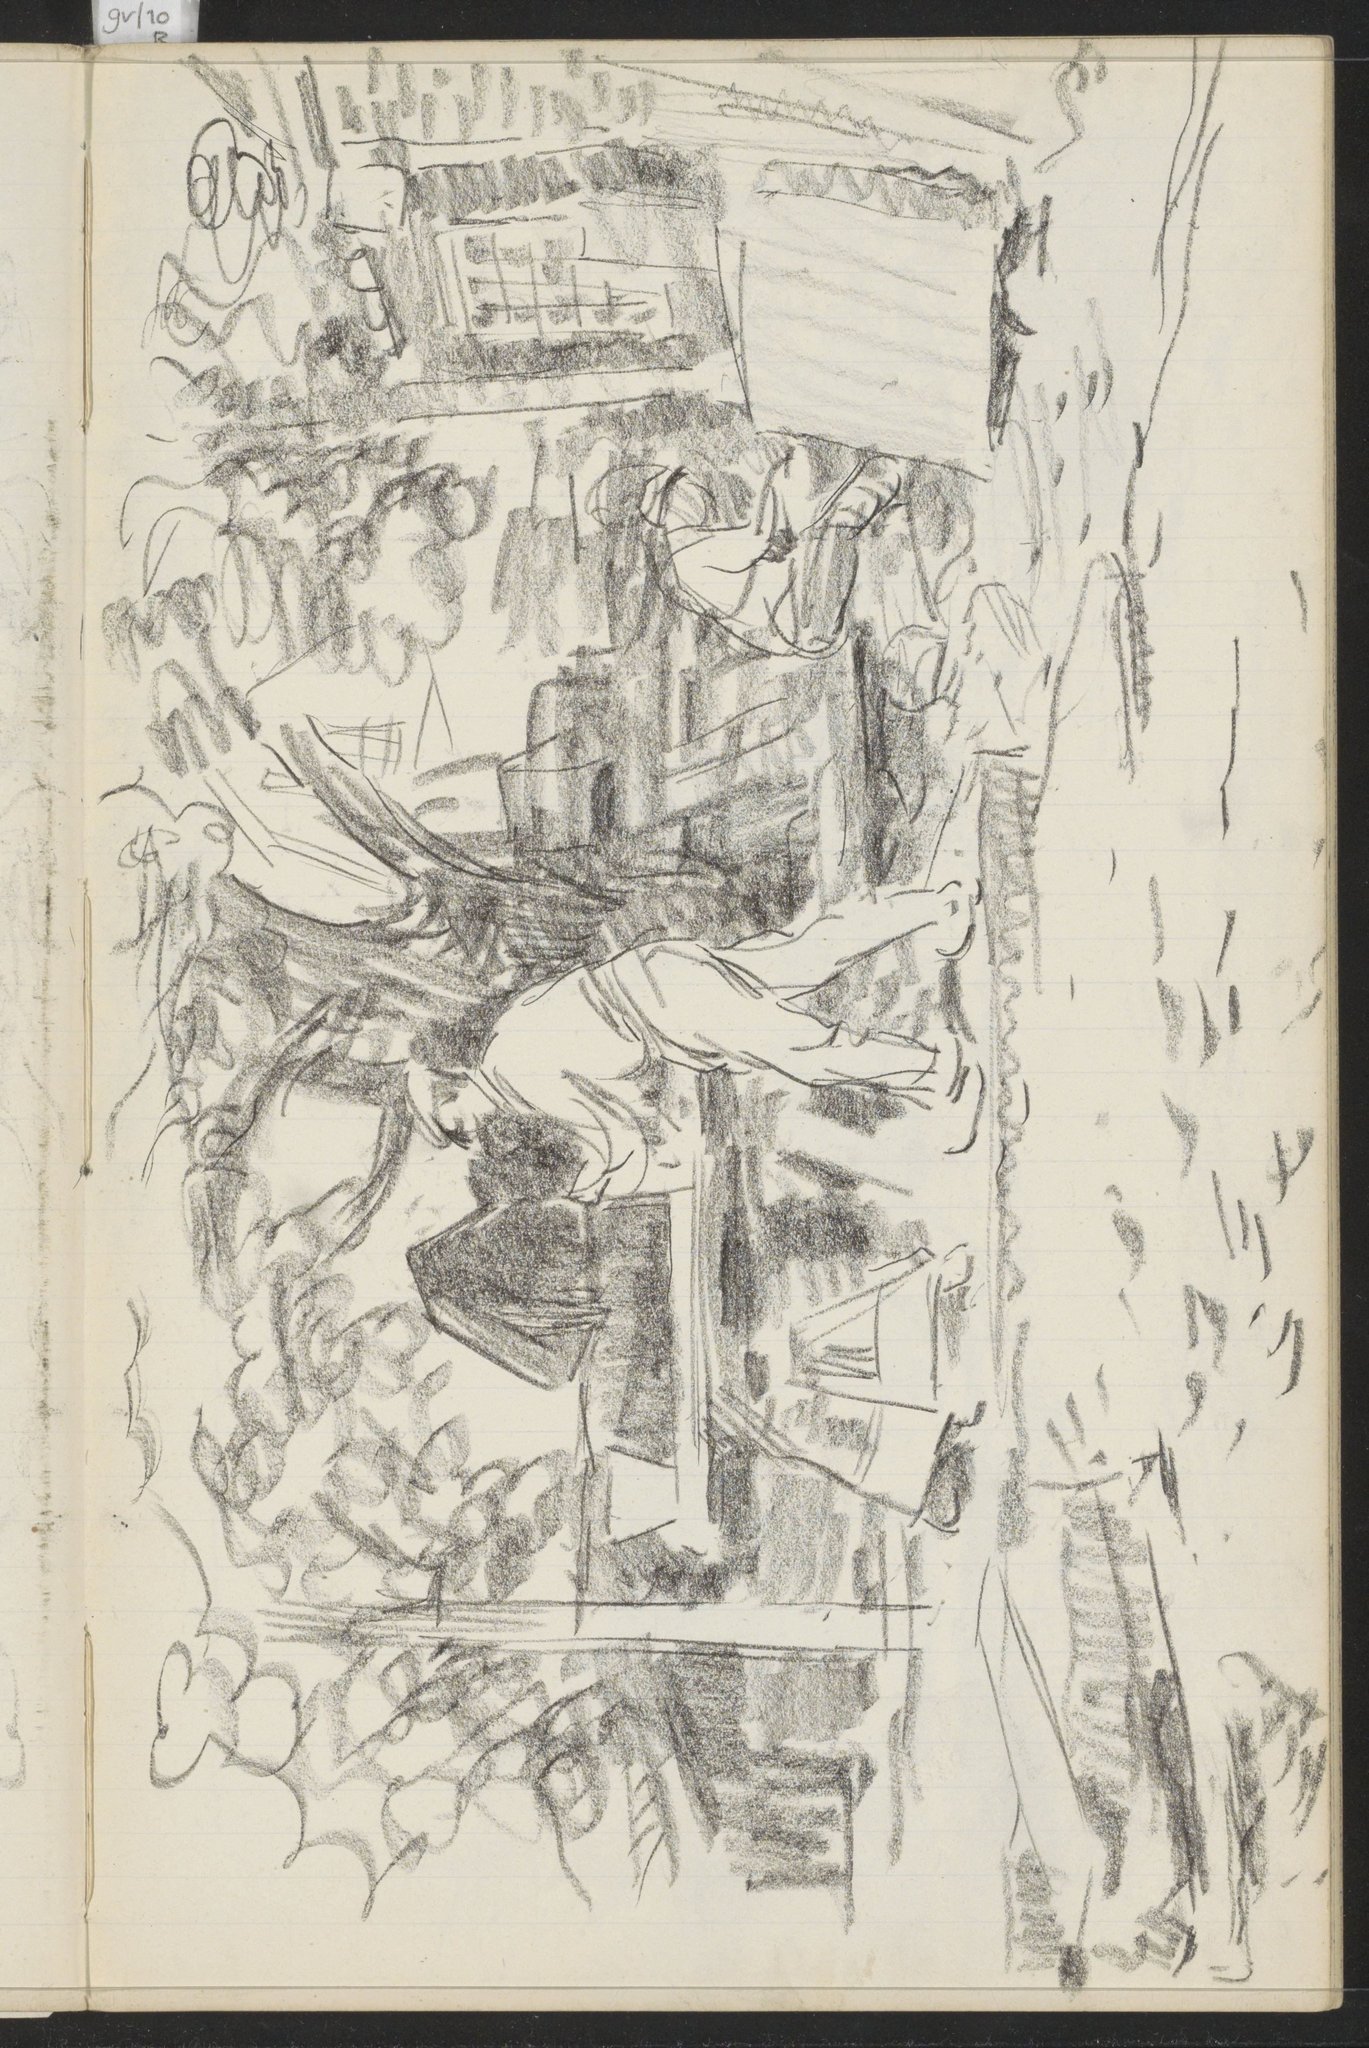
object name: sketchbook leaf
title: Twee mannen bij een werkbank in een steenhouwerij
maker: willem bastiaan tholen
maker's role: draughtsman, painter, print maker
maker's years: 1860-1931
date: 1900-1931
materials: chalk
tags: workbench, garden, adult man, workshop, handicrafts ~ wood, timber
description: De schets is vermoedelijk een voorstudie voor het schilderij 'Steenhouwerij' uit 1917 (zie documentatie).